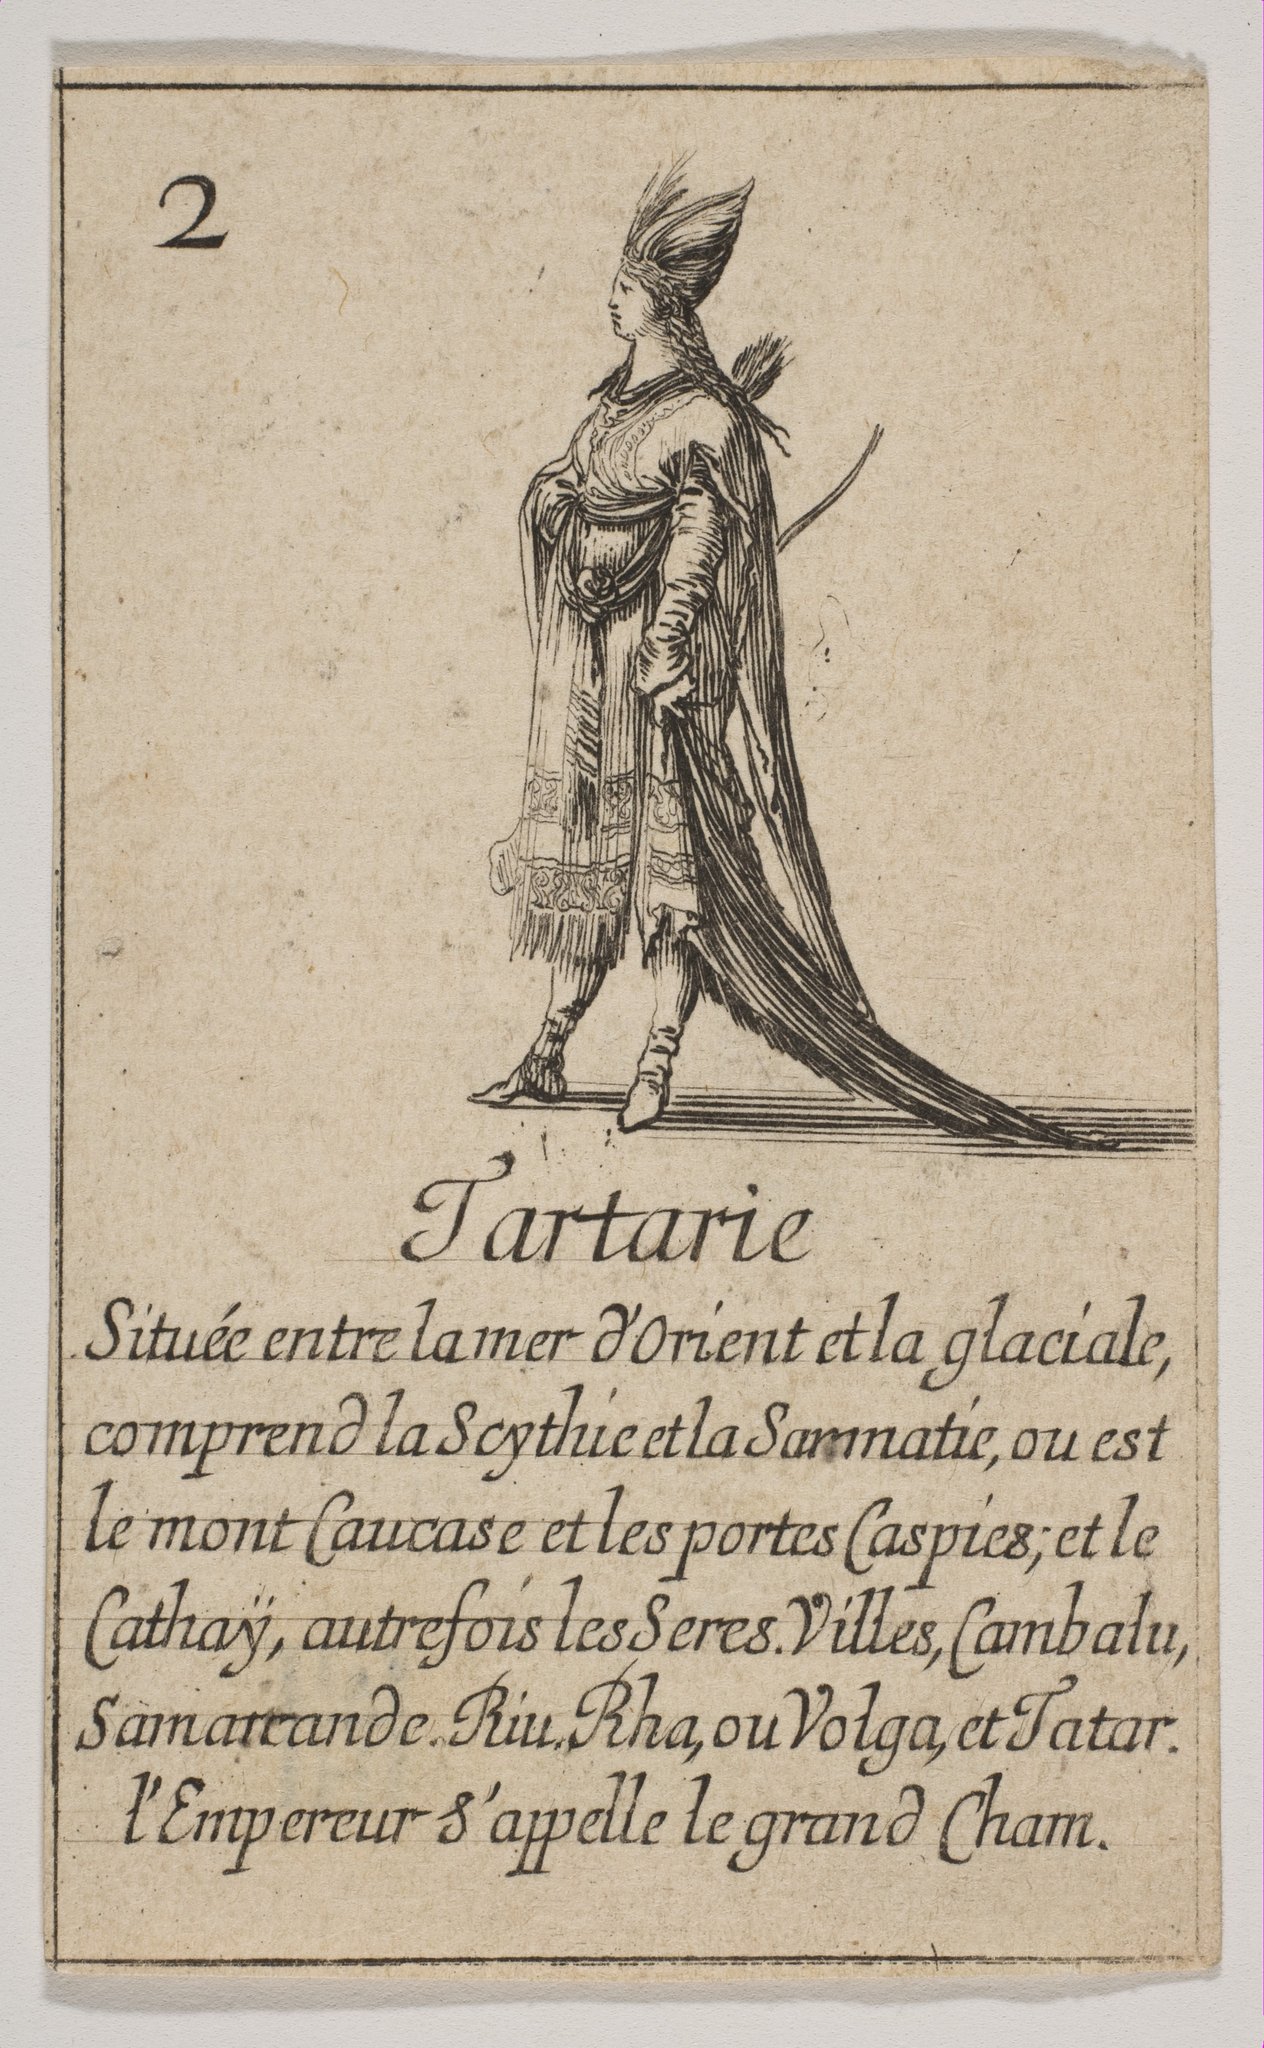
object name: print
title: Tartarie, from "Jeu de la Géographie"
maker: stefano della bella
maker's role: artist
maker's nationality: italian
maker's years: 1610-1664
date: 1644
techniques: etching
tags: kings